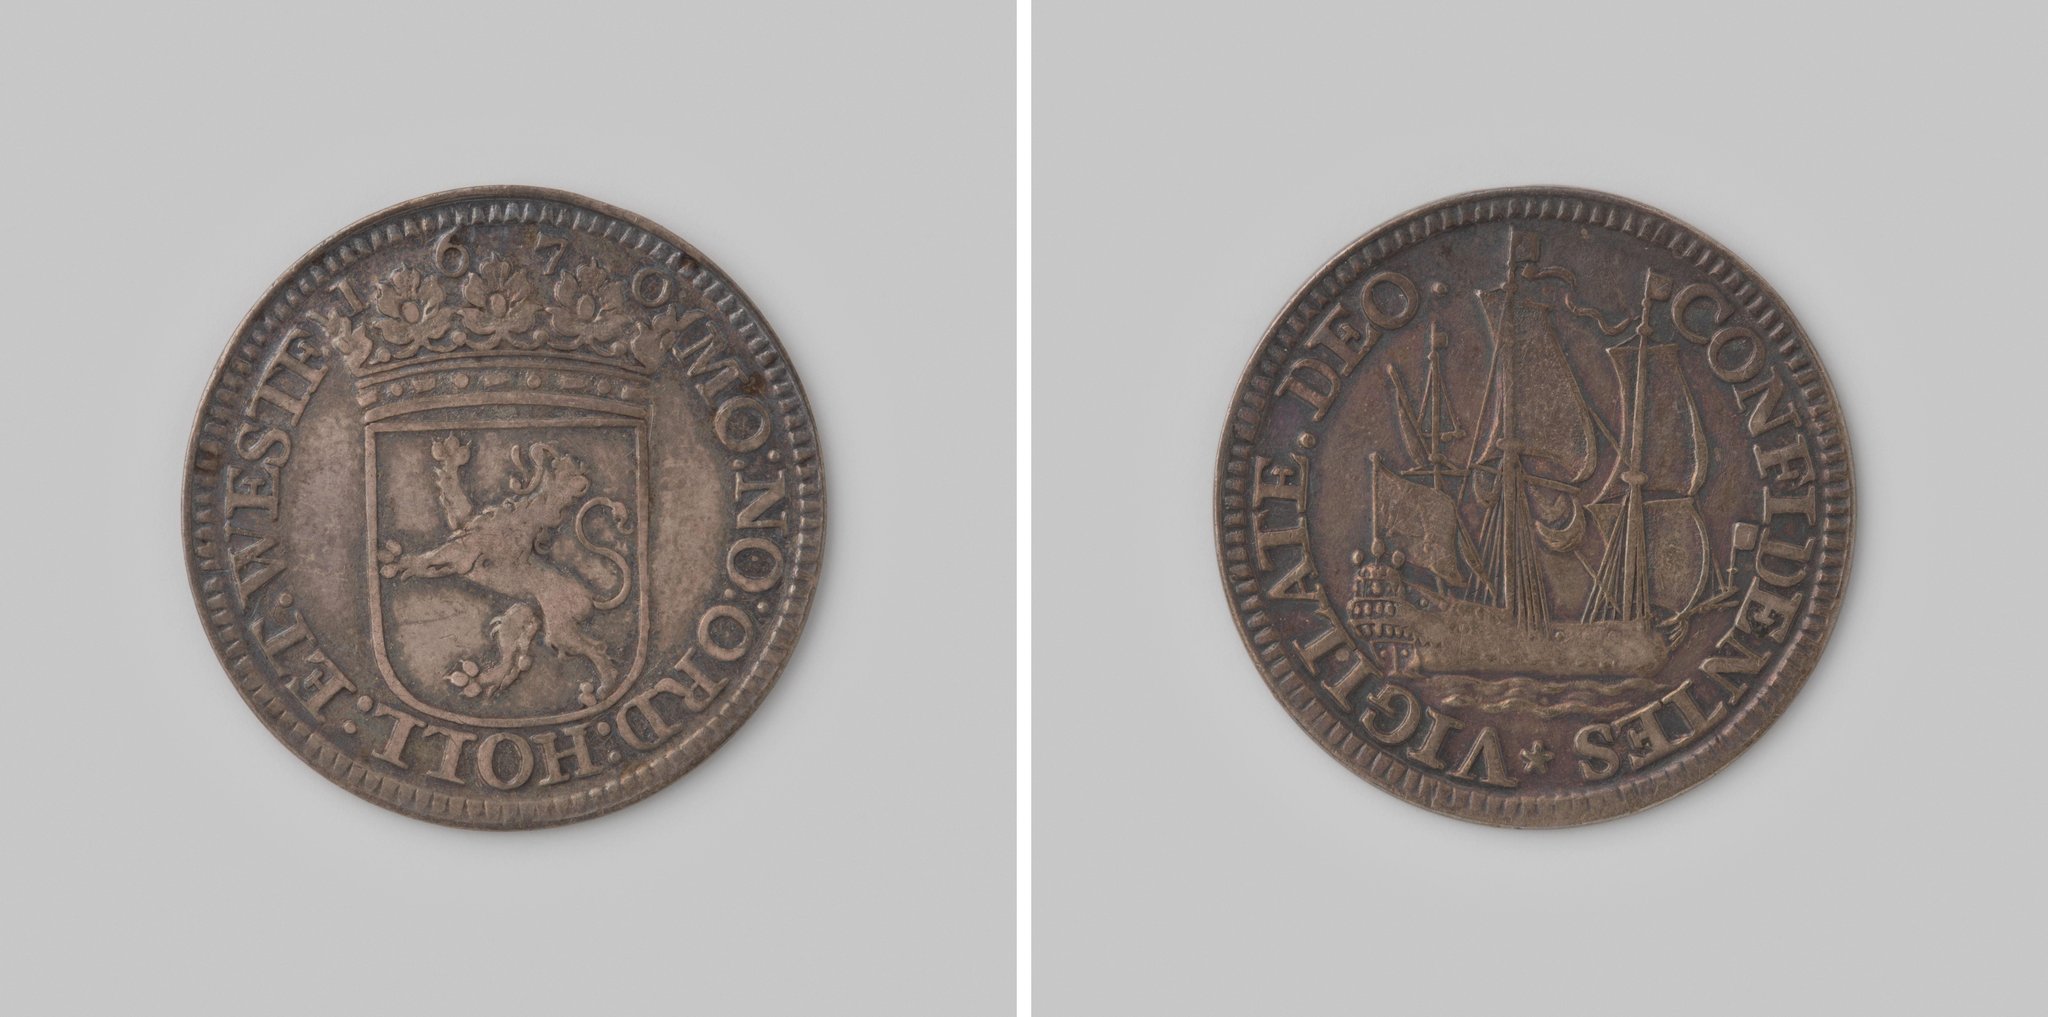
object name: coin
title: Hollandse scheepjesschelling, 1670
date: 1670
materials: silver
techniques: striking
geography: dordrecht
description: Zilveren munt. Voorzijde: gekroond wapenschild van Holland. Jaartal boven kroon. Keerzijde: oorlogsschip, varend naar rechts.